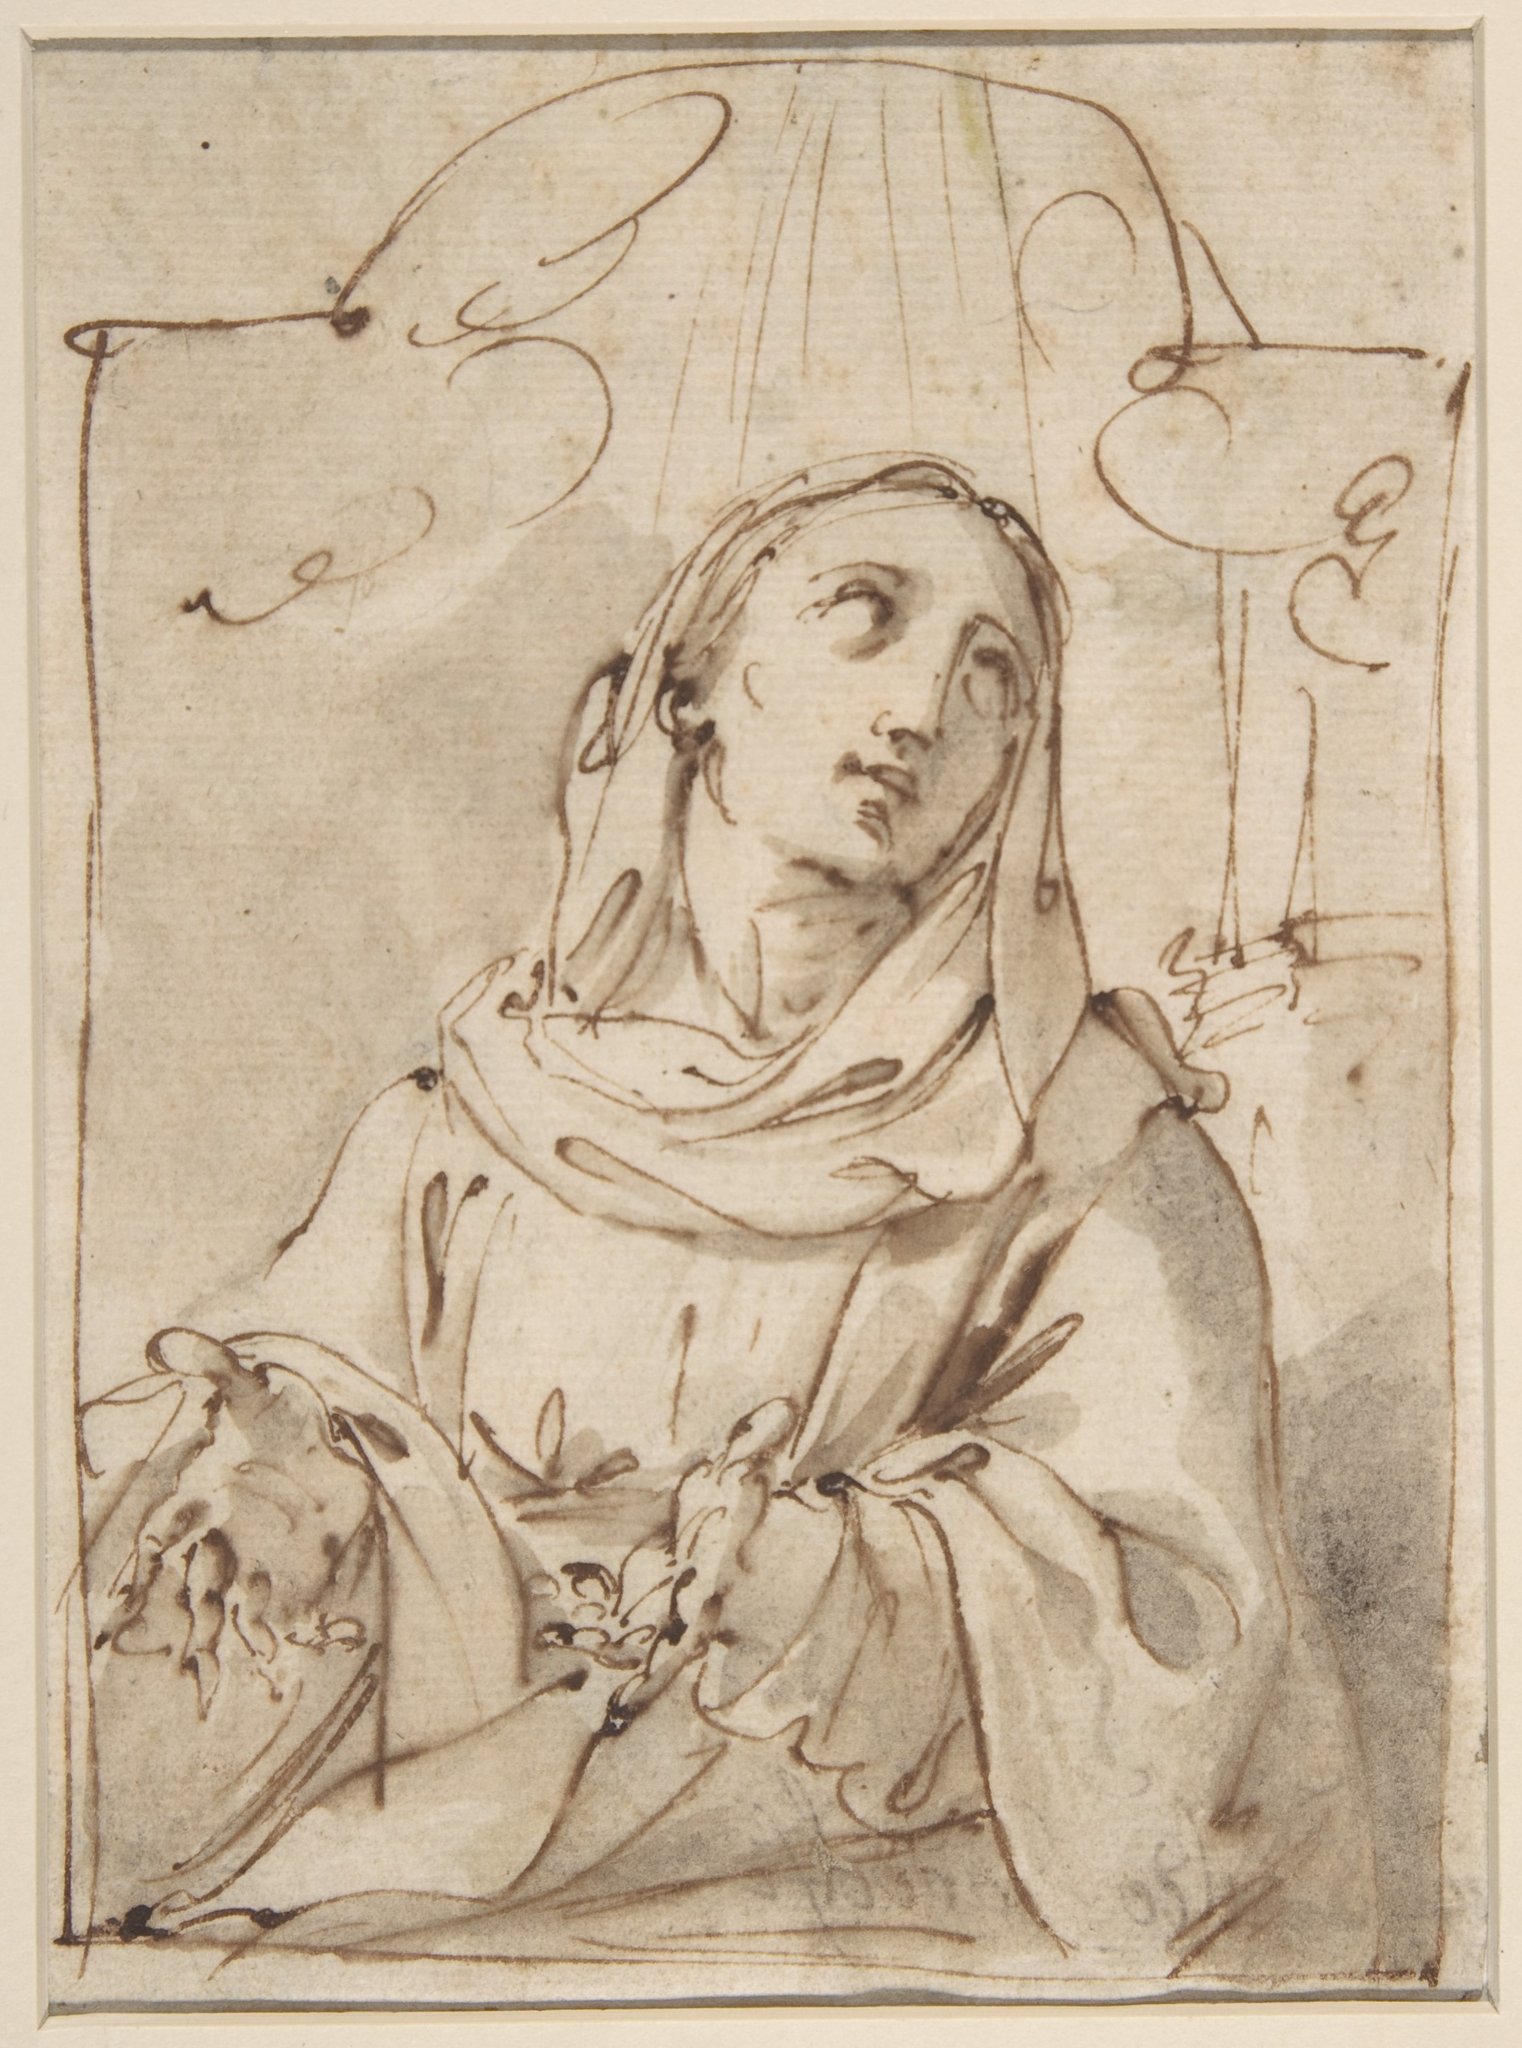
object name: drawing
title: Half Figure of a Female Saint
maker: ubaldo gandolfi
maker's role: artist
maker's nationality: italian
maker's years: 1728-1781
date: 1728-1781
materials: ink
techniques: brush, pen, wash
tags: women,saints